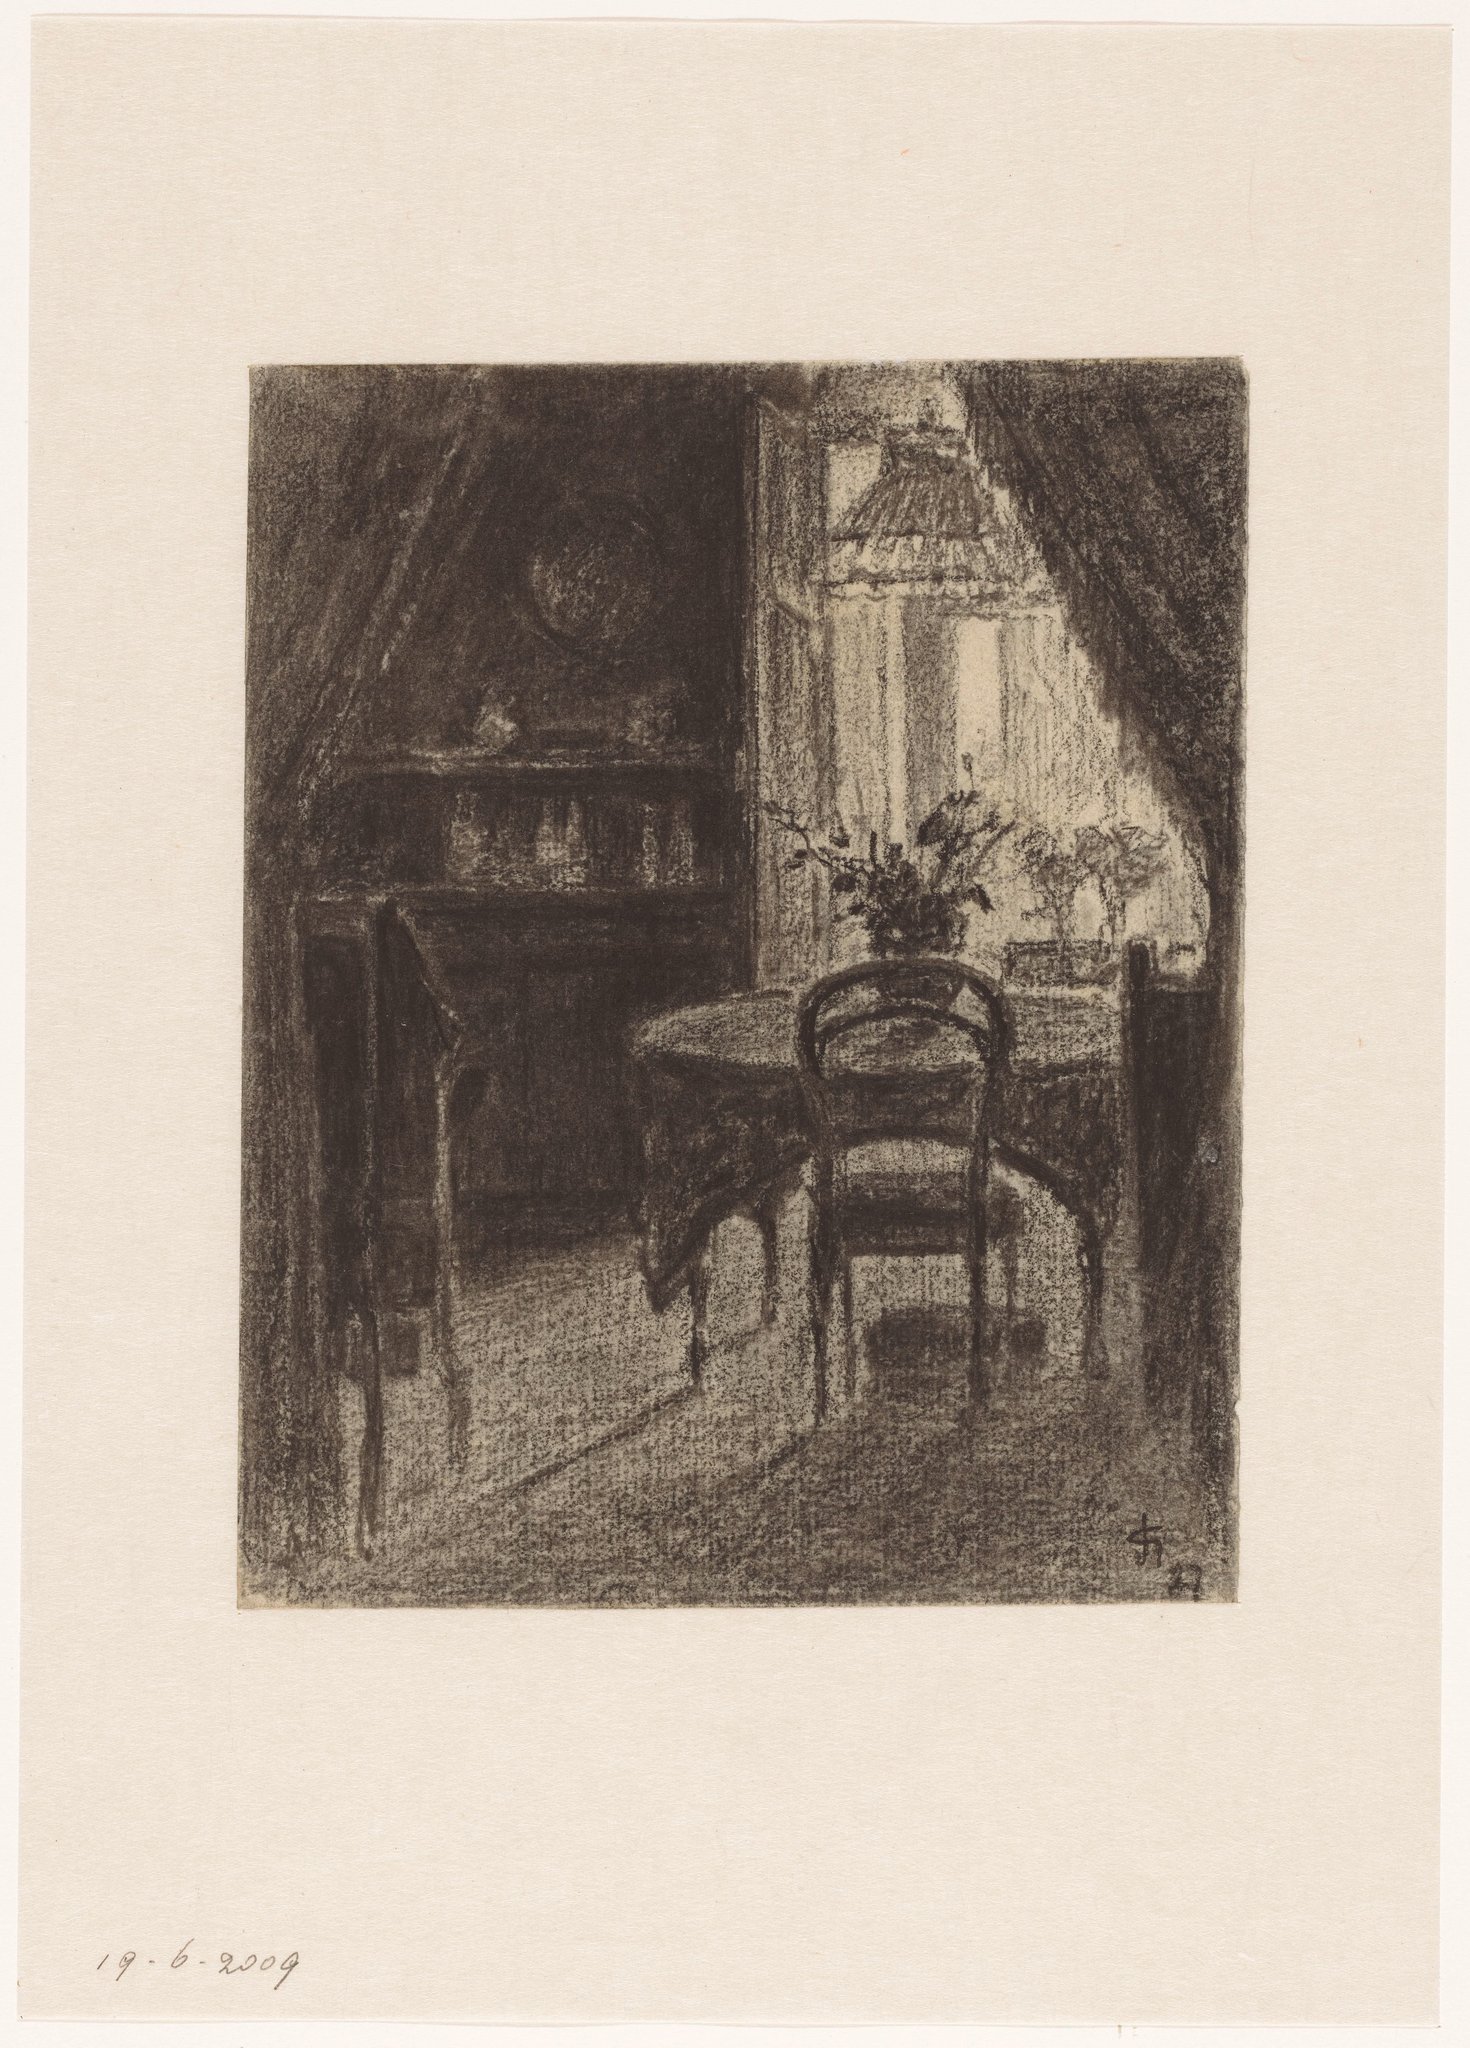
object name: drawing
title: Kamerinterieur met tafel en stoel voor het raam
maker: carel nicolaas storm van s-gravesande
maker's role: draughtsman, print maker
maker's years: 1841-1924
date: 1887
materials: chalk, charcoal, paper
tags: interior of the house